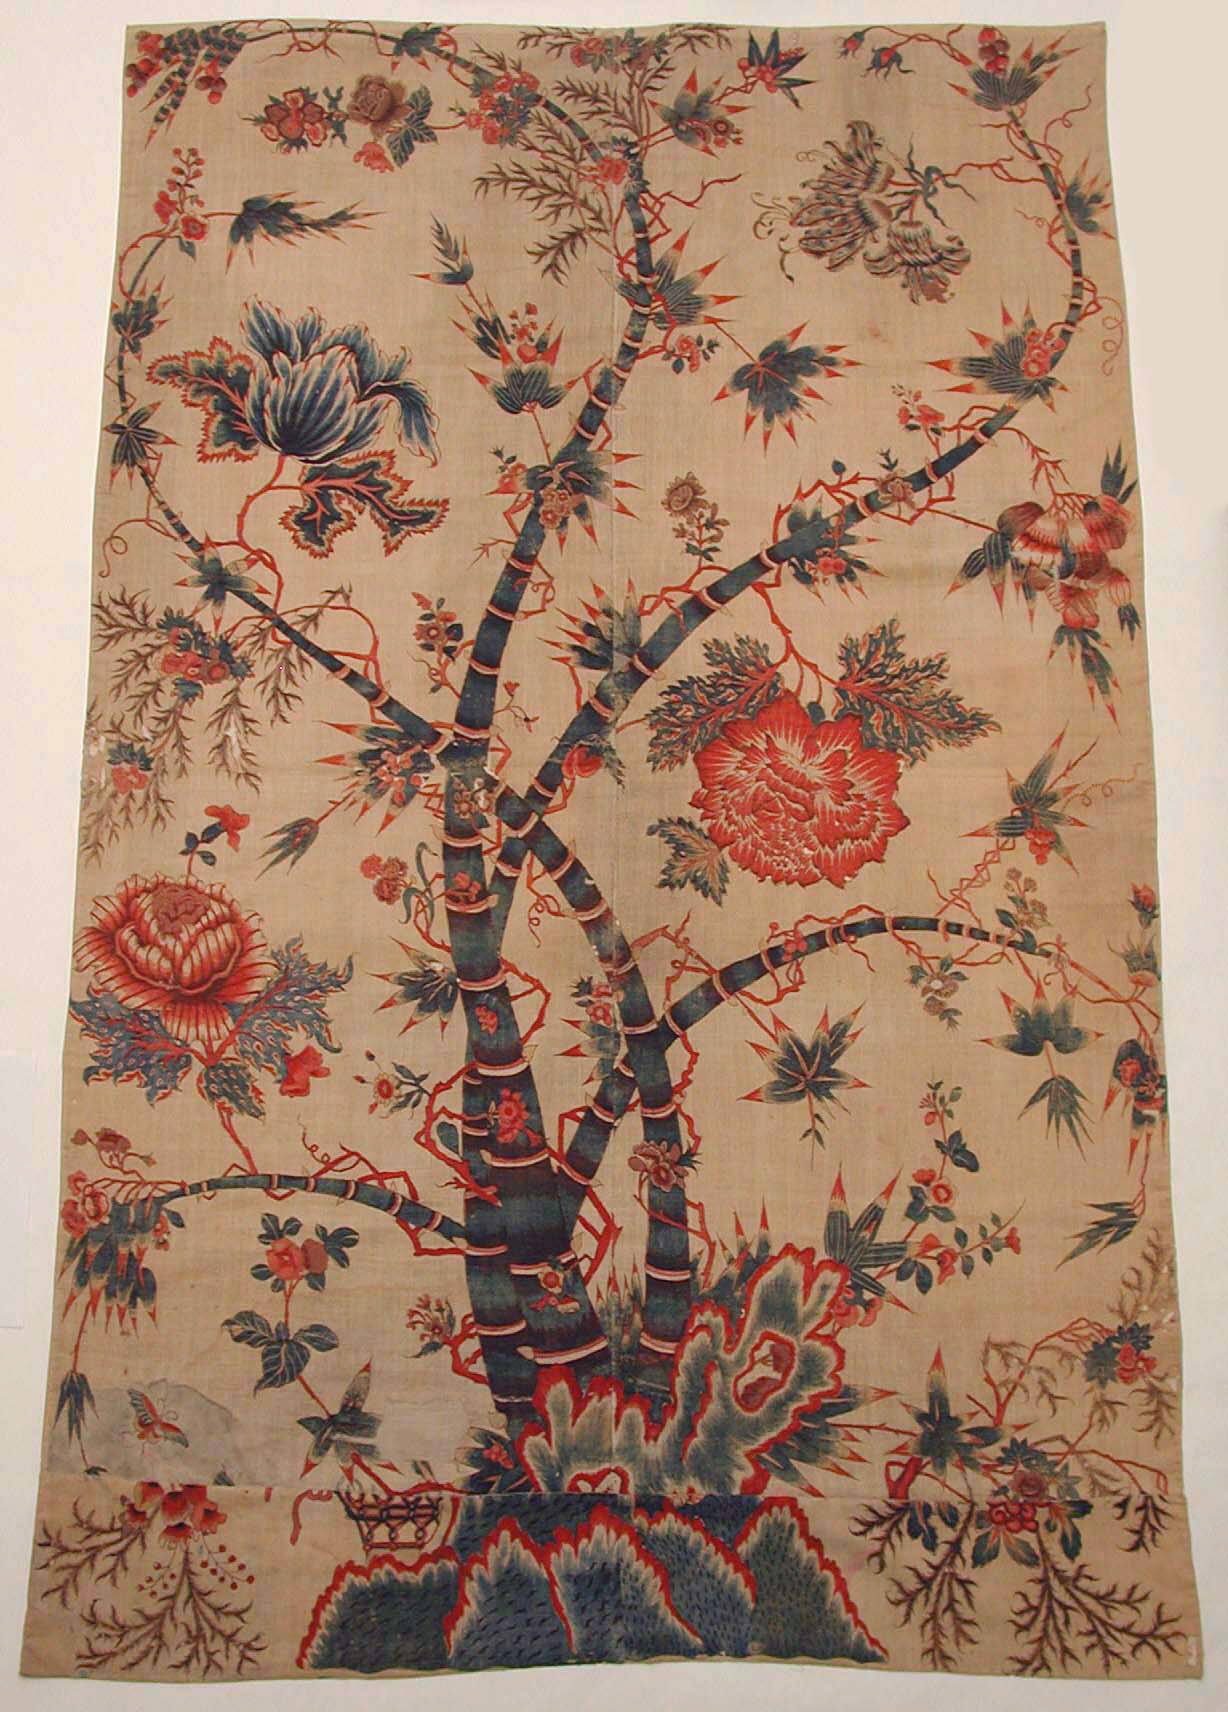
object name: hanging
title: Hanging (Palampore)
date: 1601-1700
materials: cotton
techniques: painting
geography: india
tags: flowers,trees